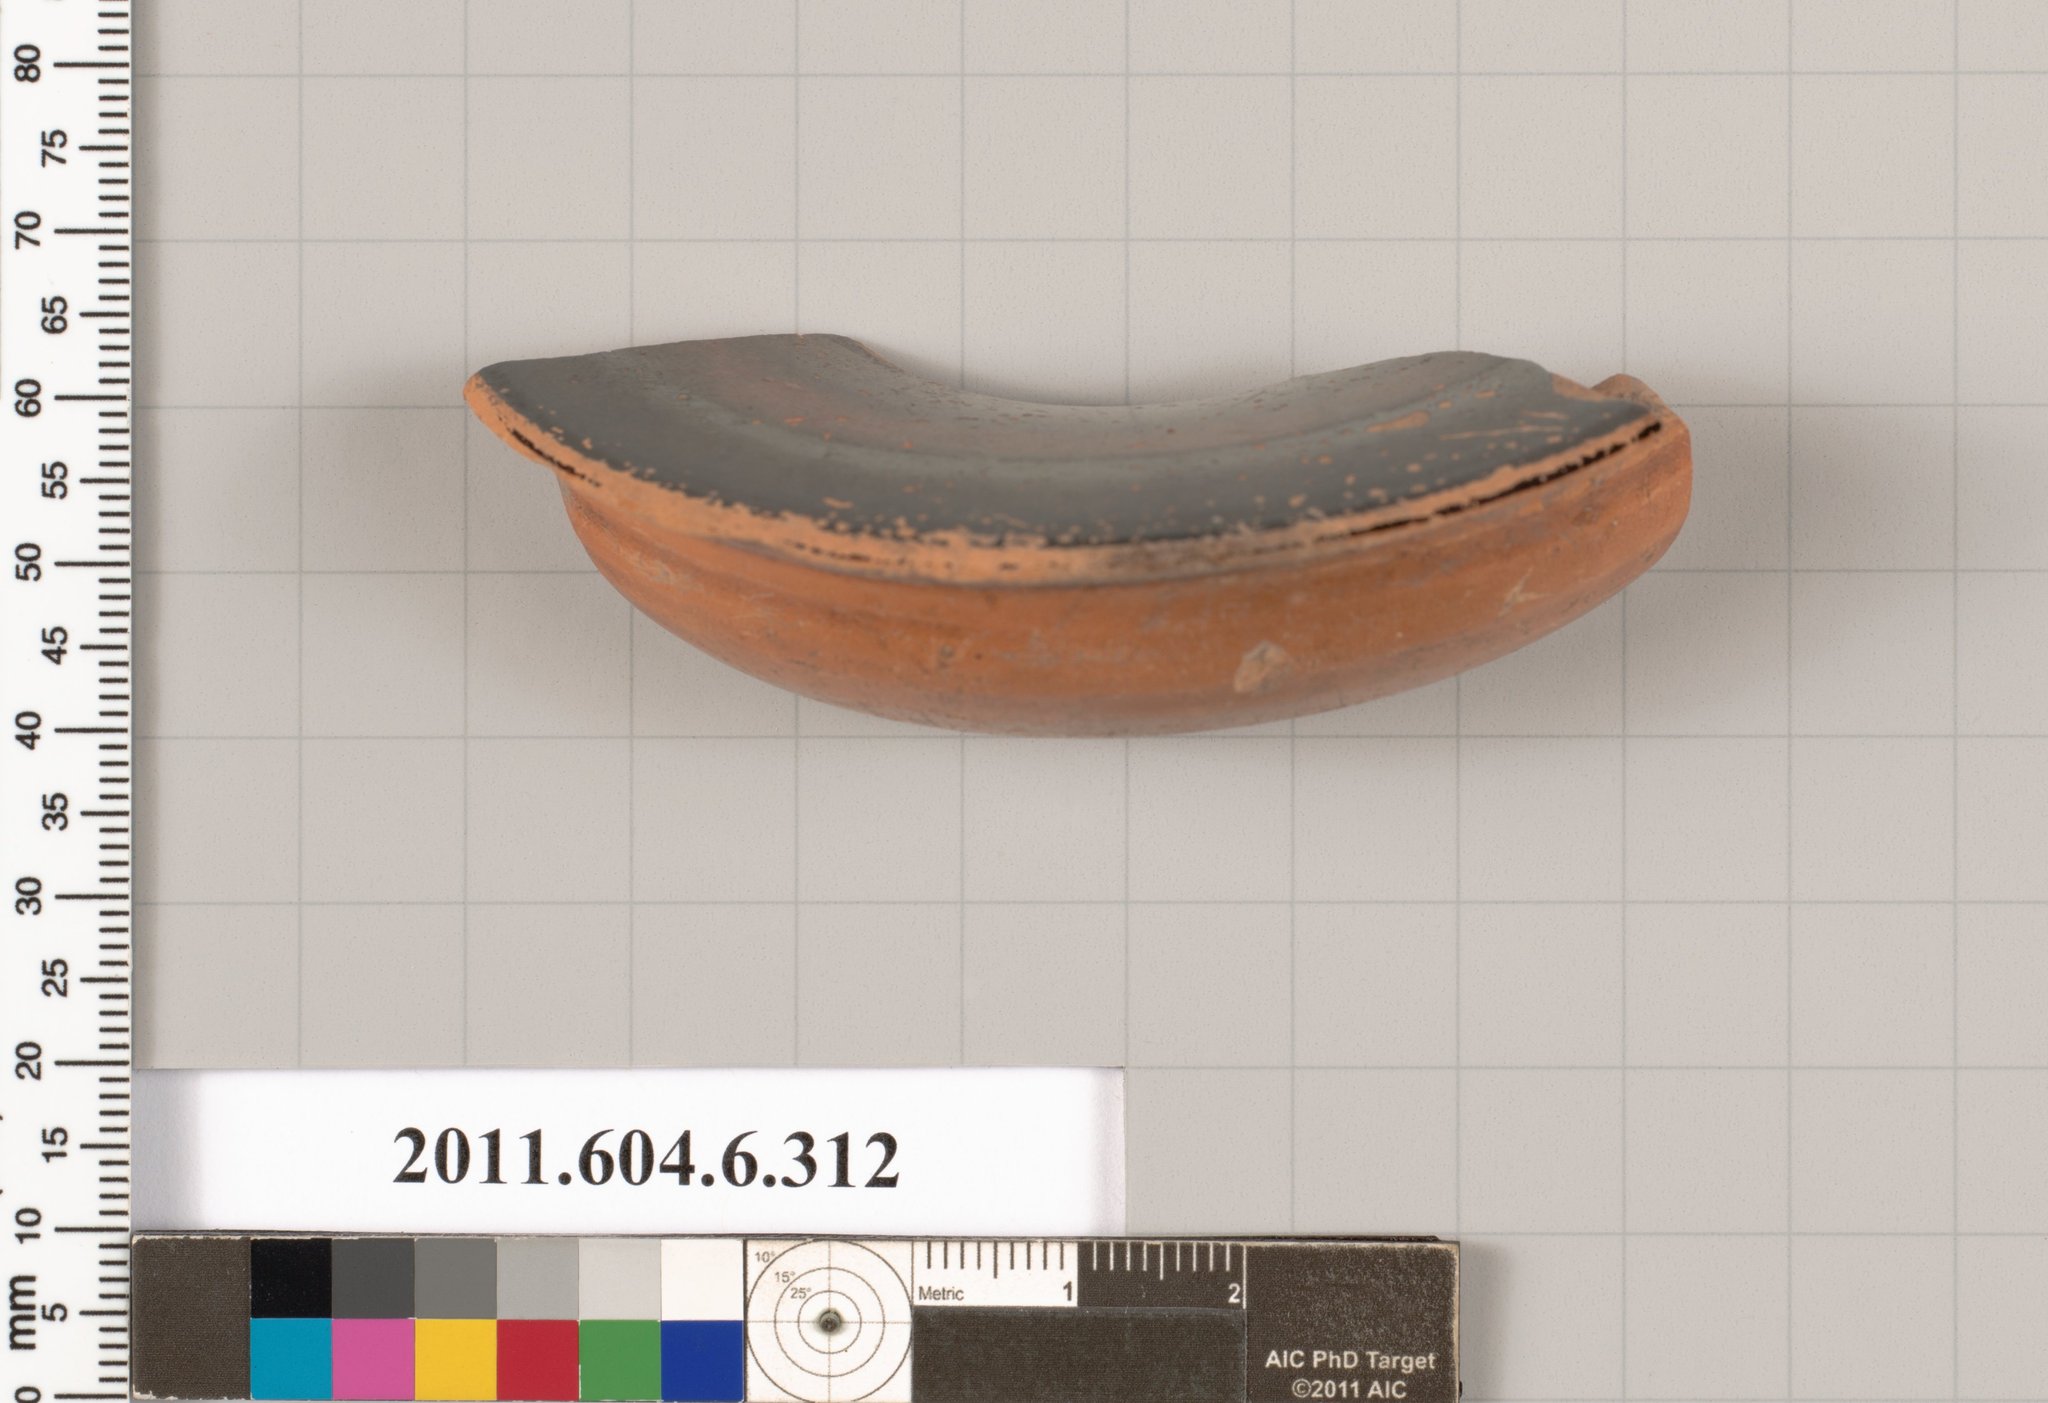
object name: lamp fragment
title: Terracotta fragment of a lamp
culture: greek, attic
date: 525-480 BCE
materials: terracotta